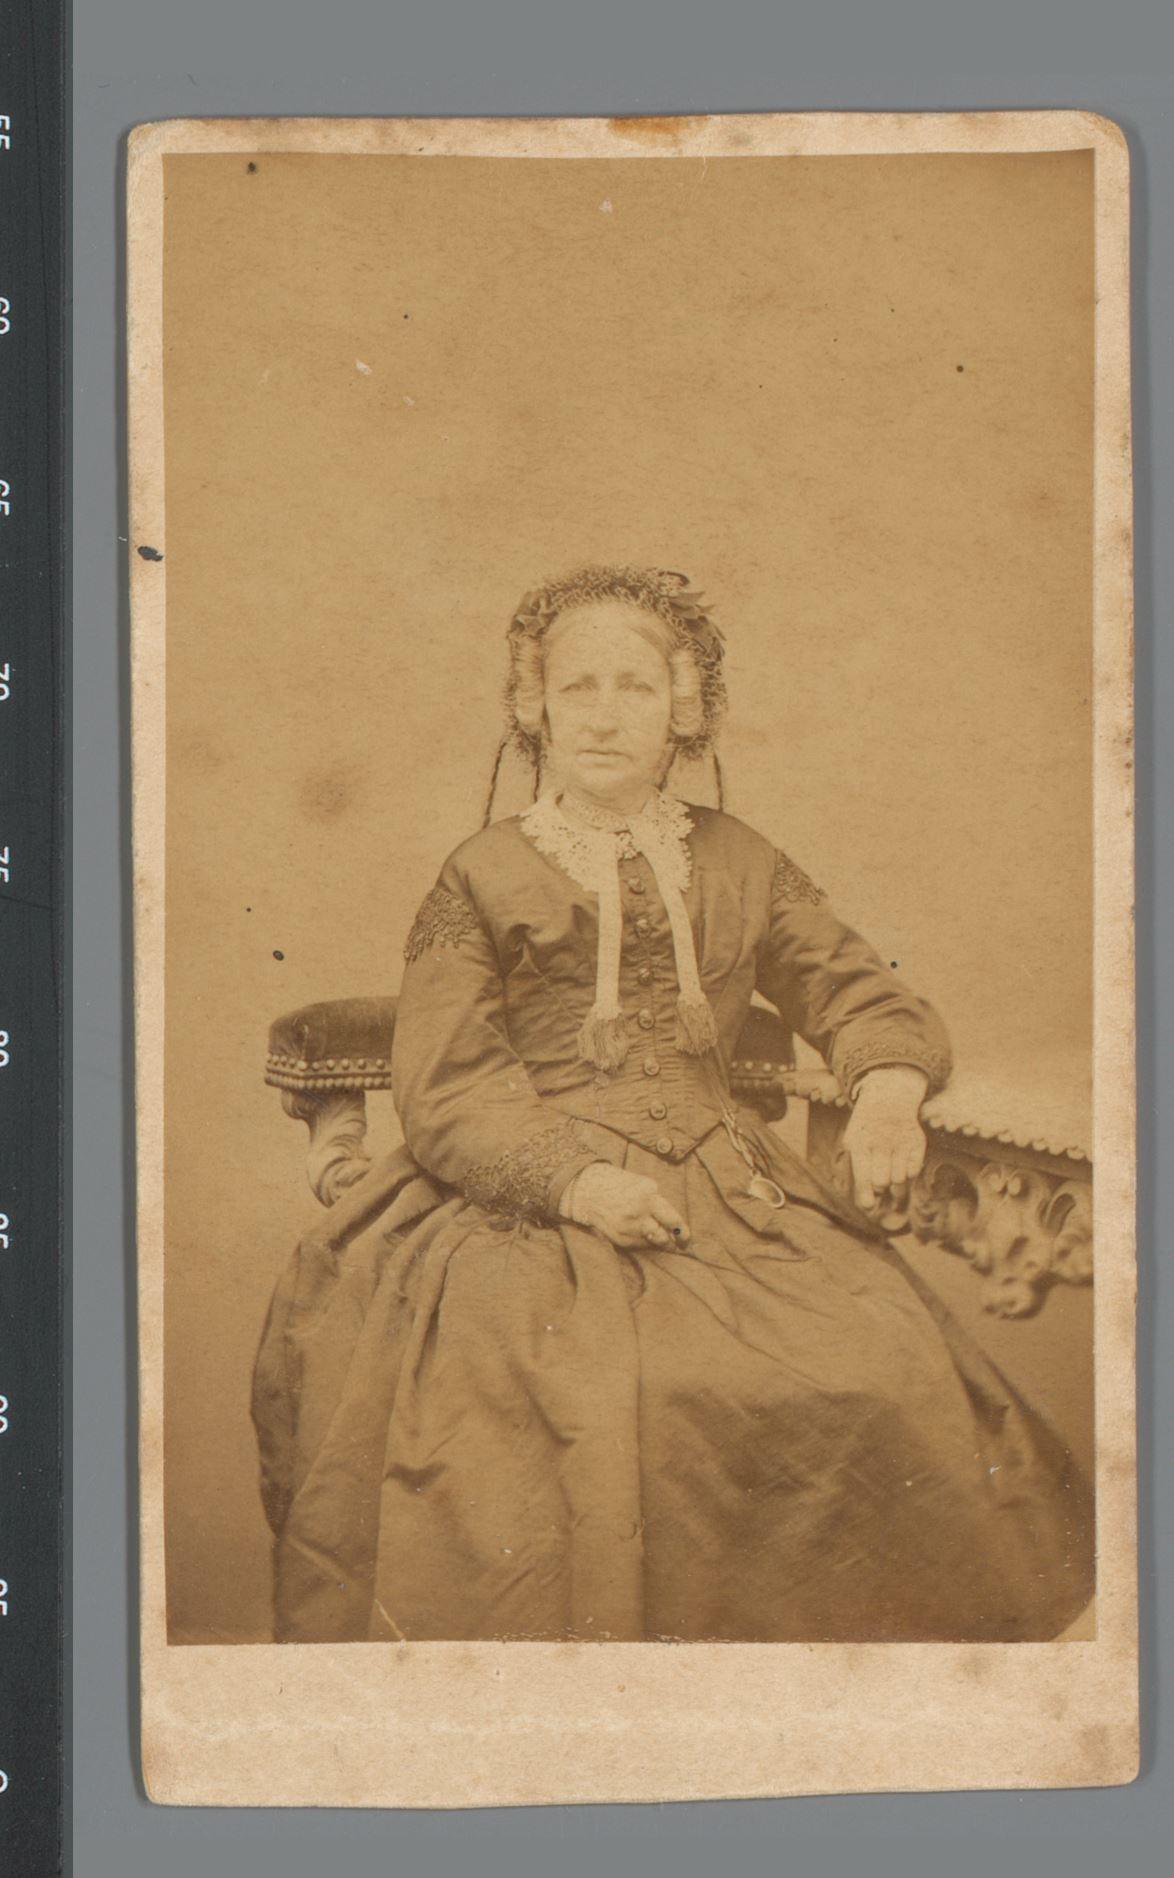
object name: photograph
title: Portret van mevrouw Nije Doorwaard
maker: albert greiner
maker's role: fotograaf, fotostudio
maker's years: 1833-1890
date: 1861-1874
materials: cardboard, photographic support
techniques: albumen print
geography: amsterdam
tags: historical persons - bb - woman, amsterdam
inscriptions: workshop stamp: ‘A. Greiner/ Photograf/ Nieuwendijk L.87, Amsterdam’, annotation: ‘Grootmoeder Nije-Doorwaard’